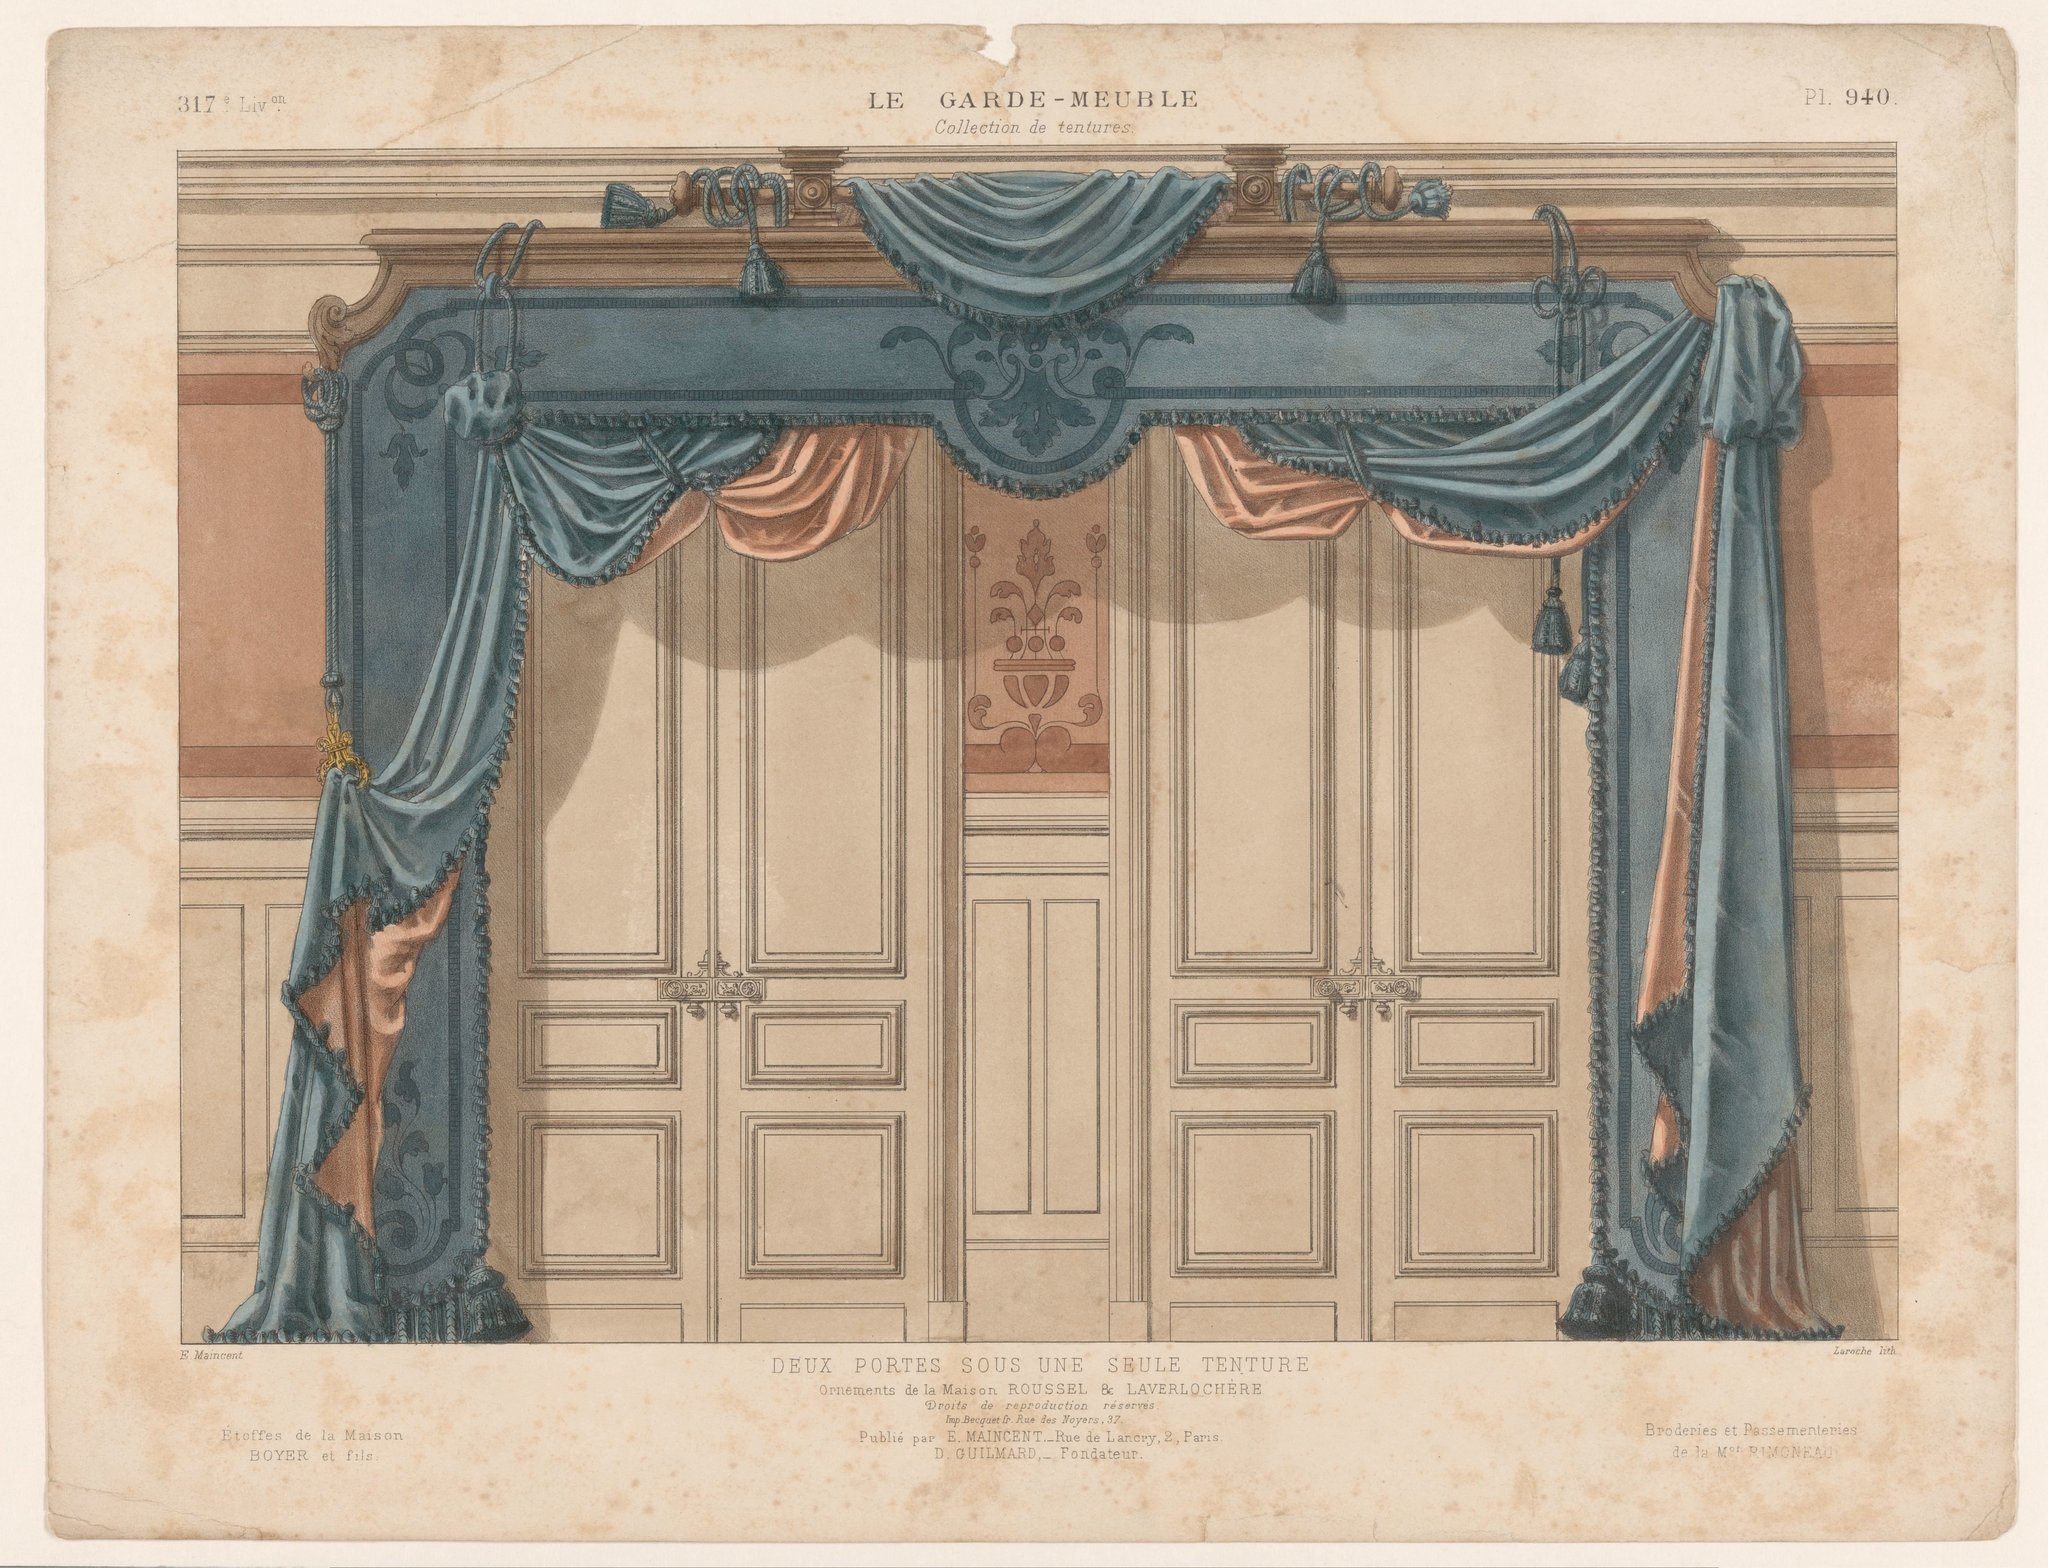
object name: print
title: Le Garde-Meuble / Collection de Tentures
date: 1885-1895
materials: paper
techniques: hand coloring, lithograph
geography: paris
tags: door, hangings and drapery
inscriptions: : ‘Droits de reproduction réservés.’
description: Twee deuren met één gedrapeerd gordijn. Prent uit 317e Livraison.